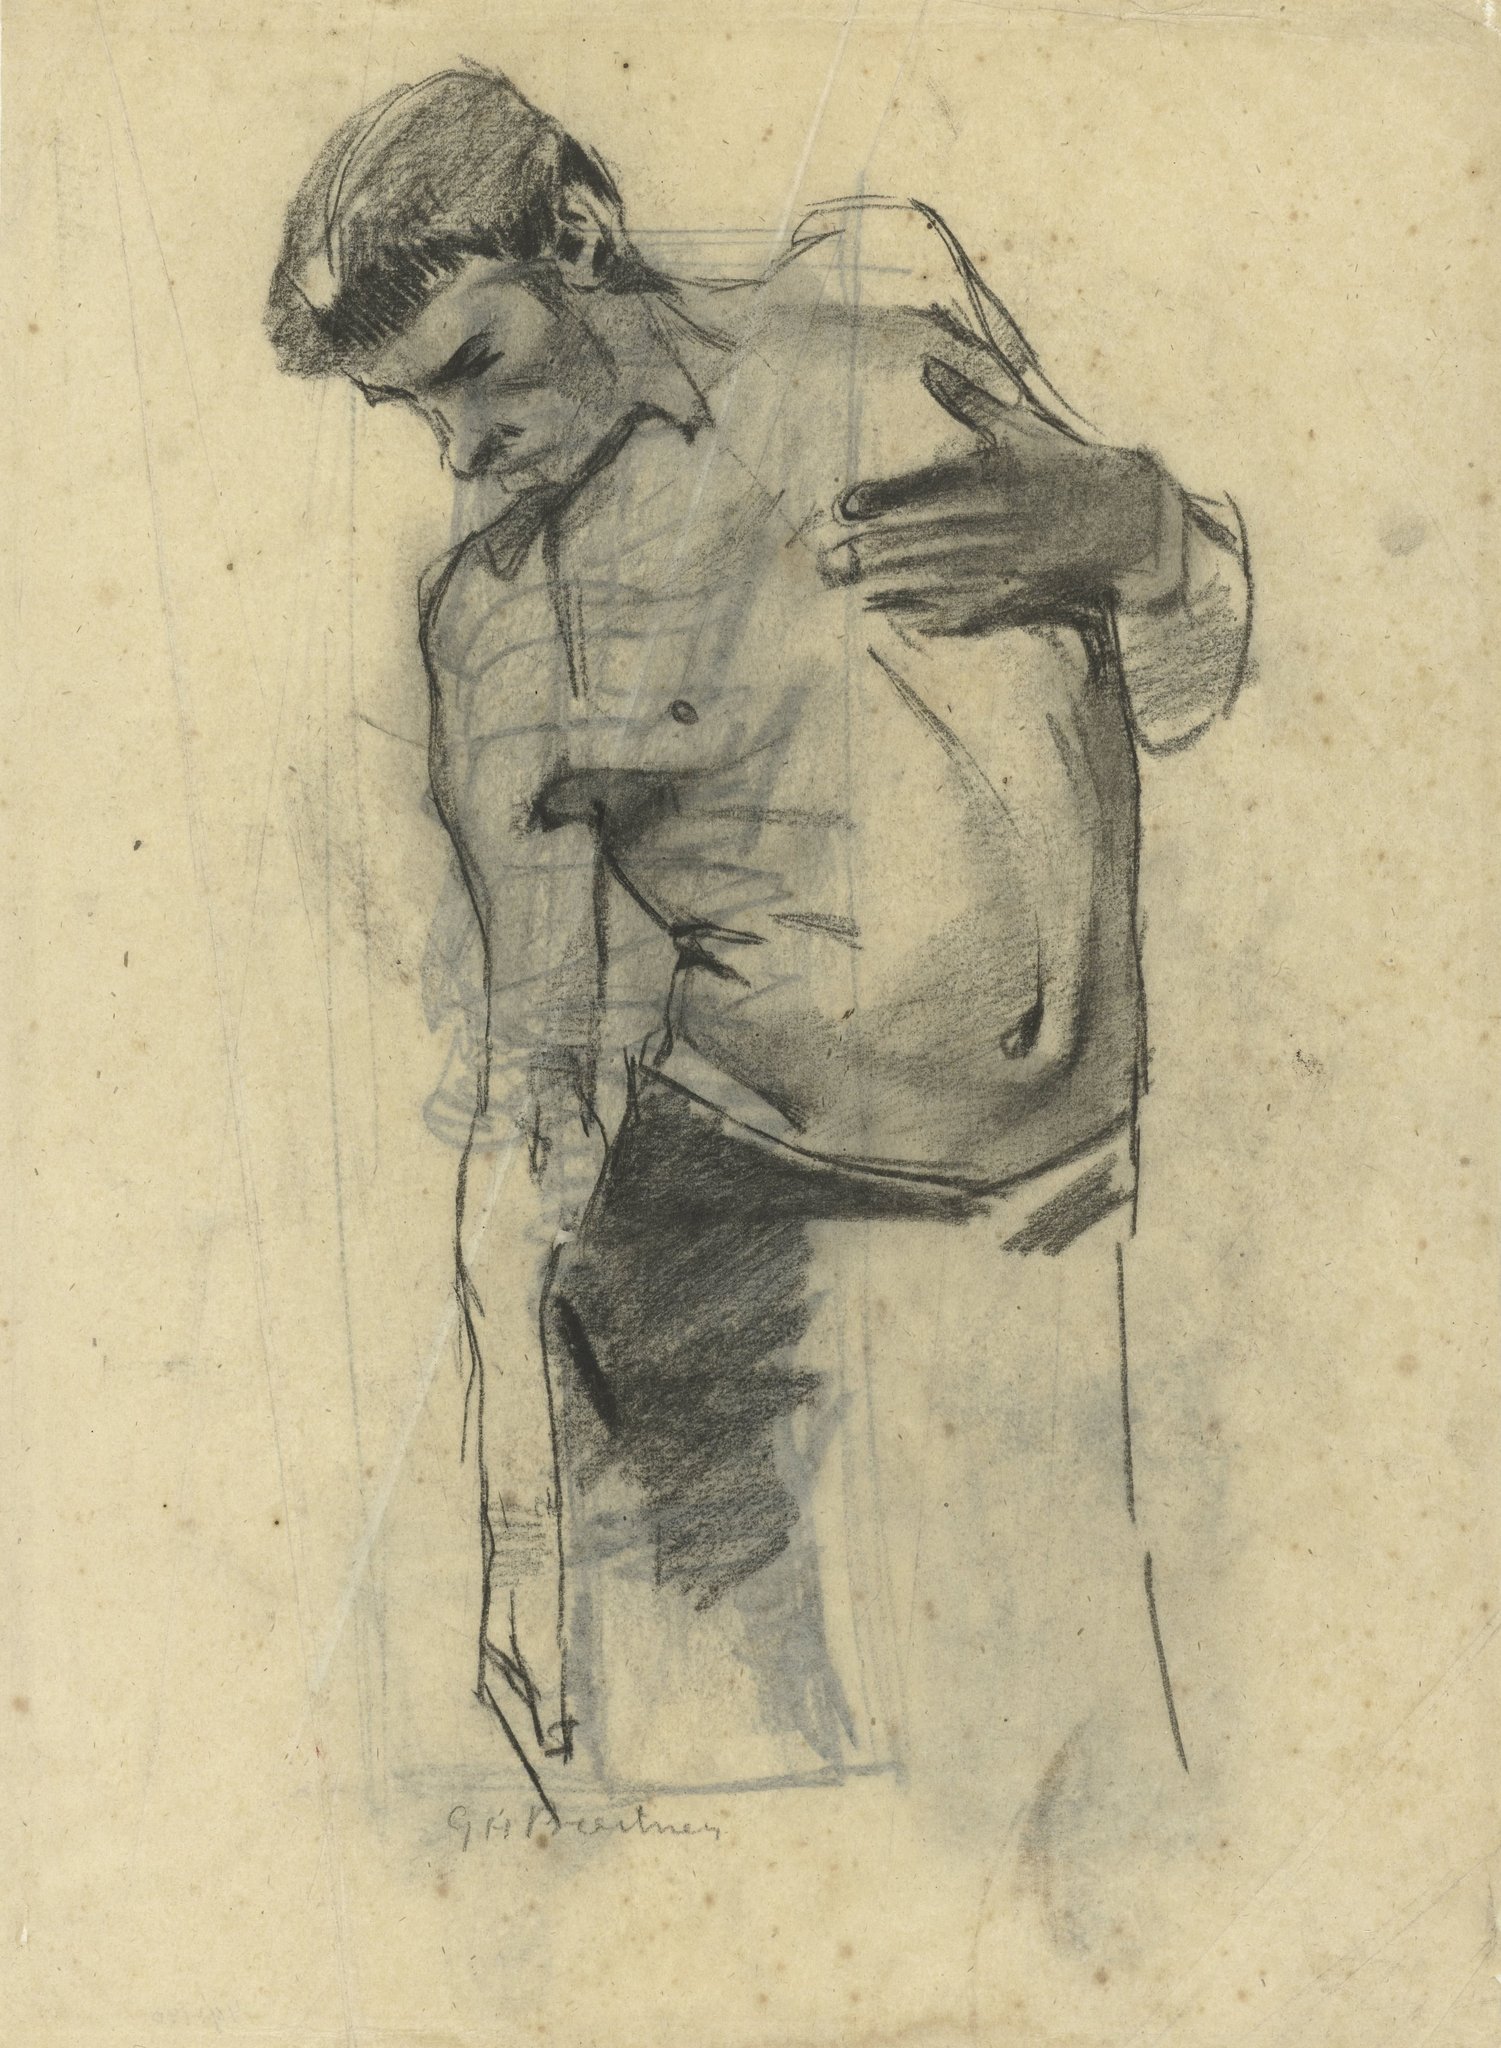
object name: drawing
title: Modelstudie van staande halfnaakte man, naar omlaag ziende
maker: george hendrik breitner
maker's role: draughtsman, painter, print maker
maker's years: 1857-1923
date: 1867-1923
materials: chalk, paper